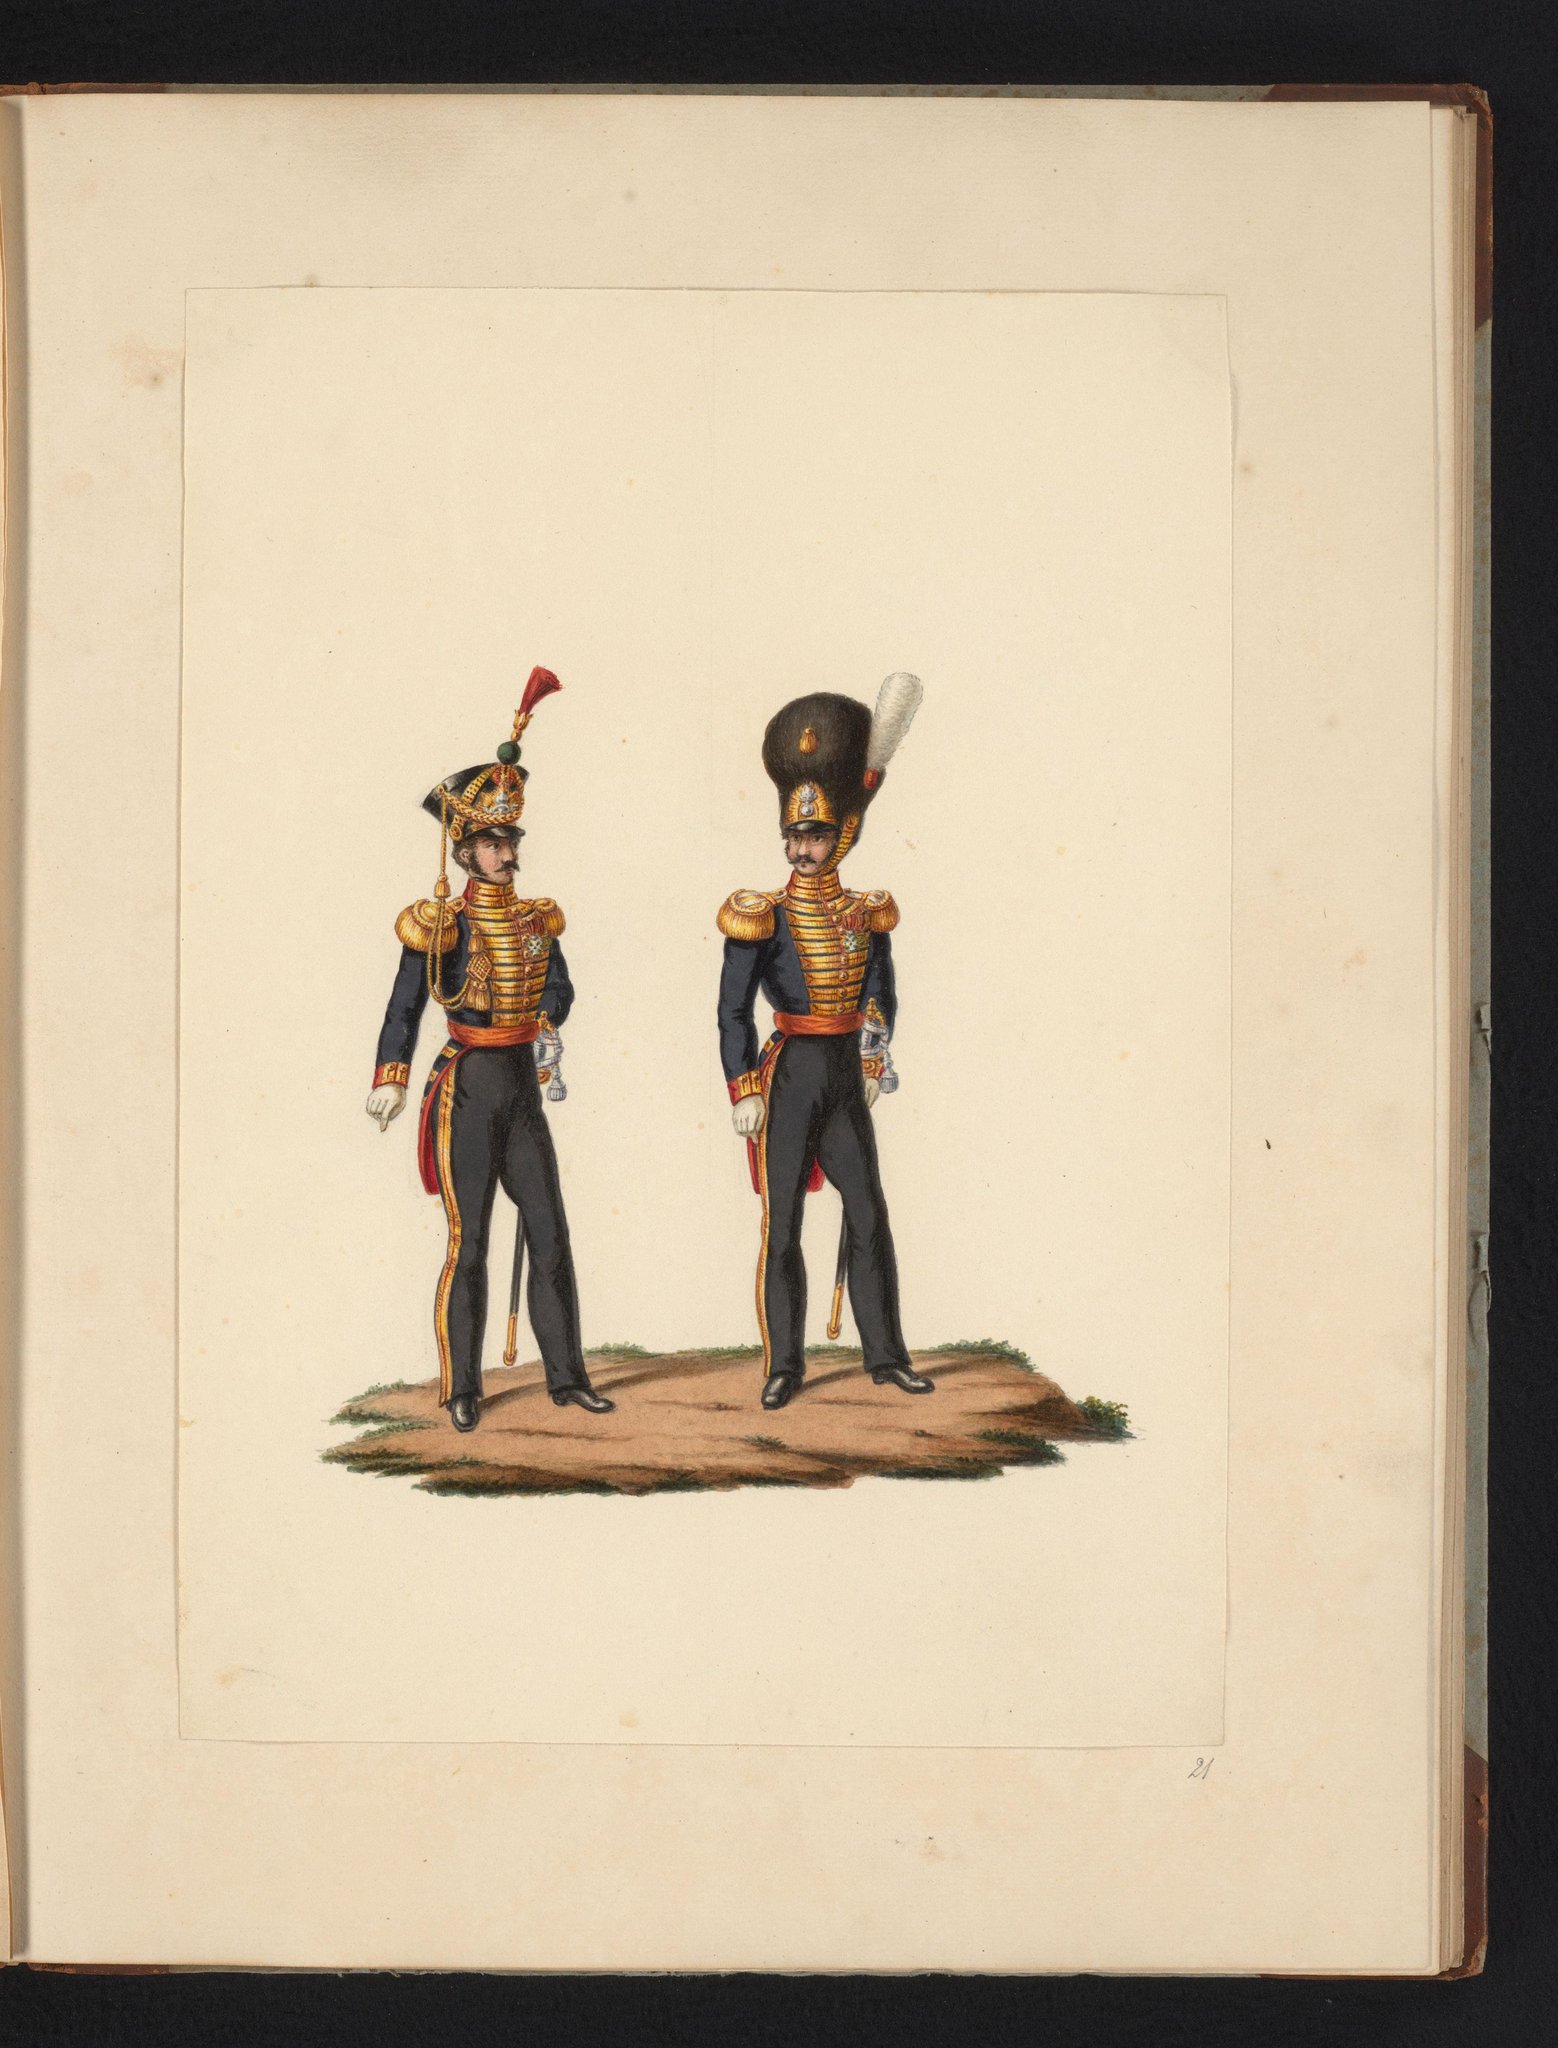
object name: drawing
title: Kapitein en tweede luitenant van de grenadiers, 1830-1831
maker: Anonymous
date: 1831-1832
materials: paper, pencil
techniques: brush, lacquer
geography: netherlands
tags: professional clothes, (military) uniforms, netherlands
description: Een kapitein en een tweede luitenant van de grenadiers, te voet. Onderdeel van het album met 39 ingeplakte tekeningen van militairen van de Koninklijke Nederlandsche Armee uit 1830-1831.